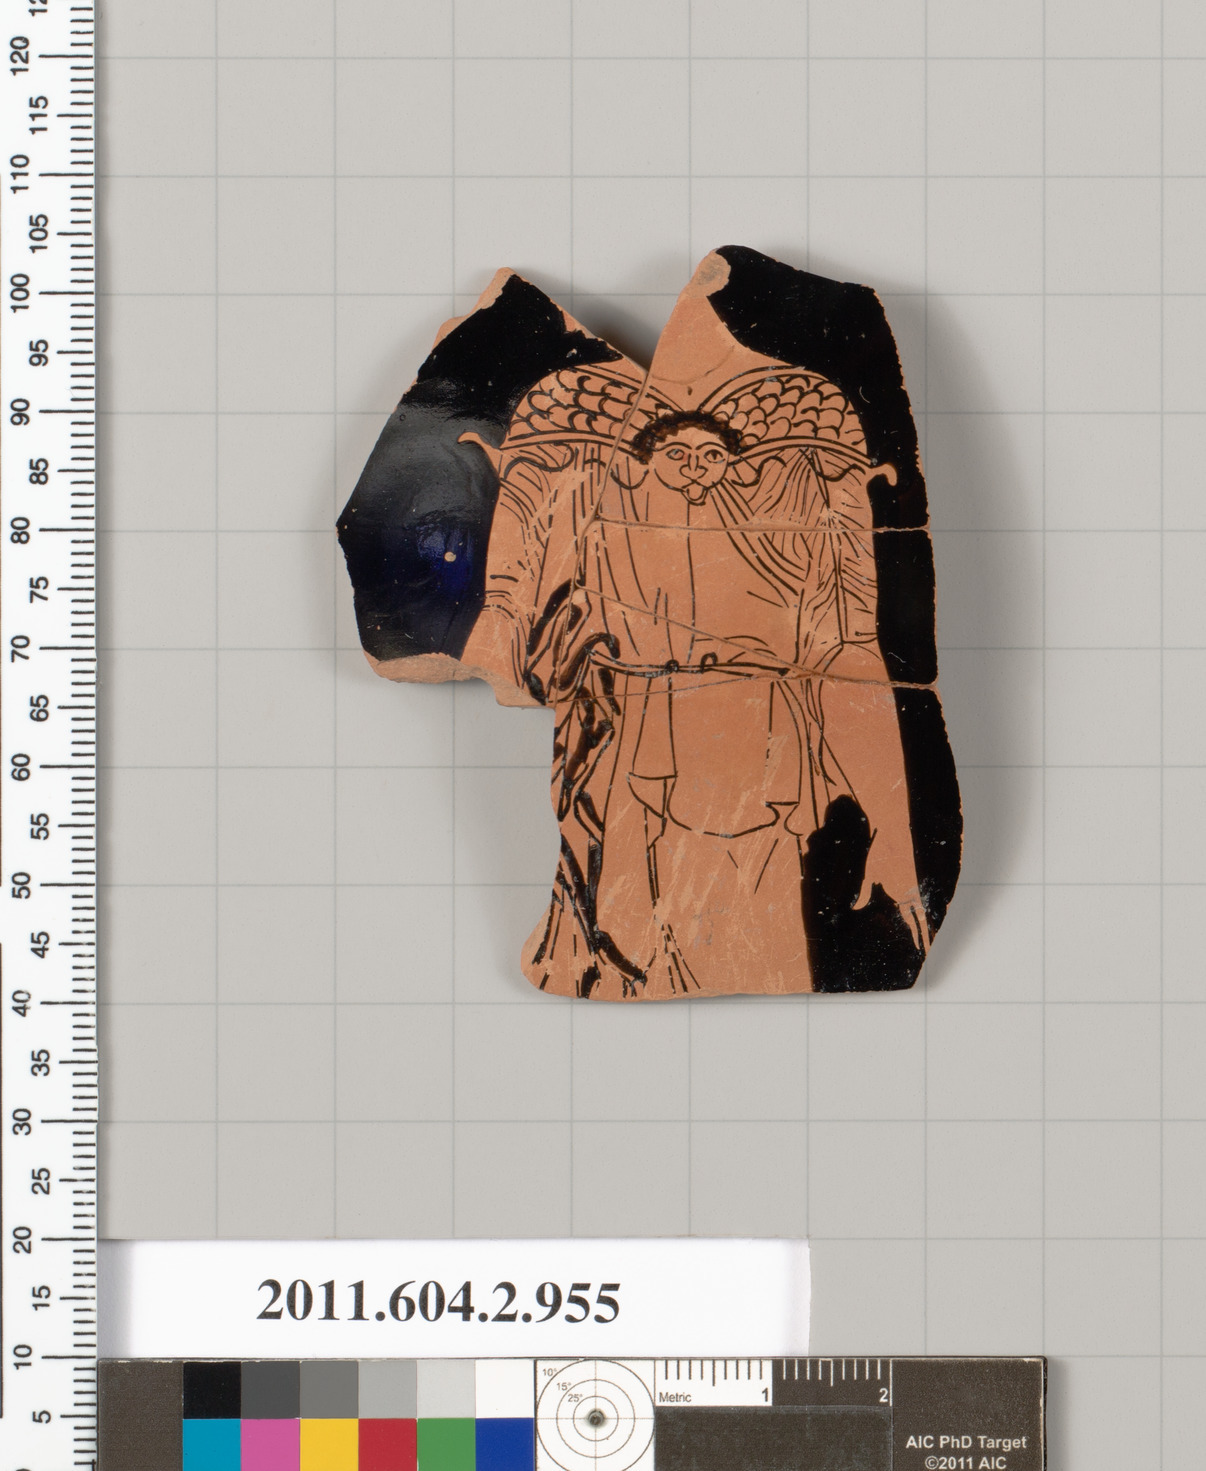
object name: oinochoe fragment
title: Terracotta fragment of an oinochoe (jug)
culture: greek, attic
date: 475-451 BCE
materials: terracotta